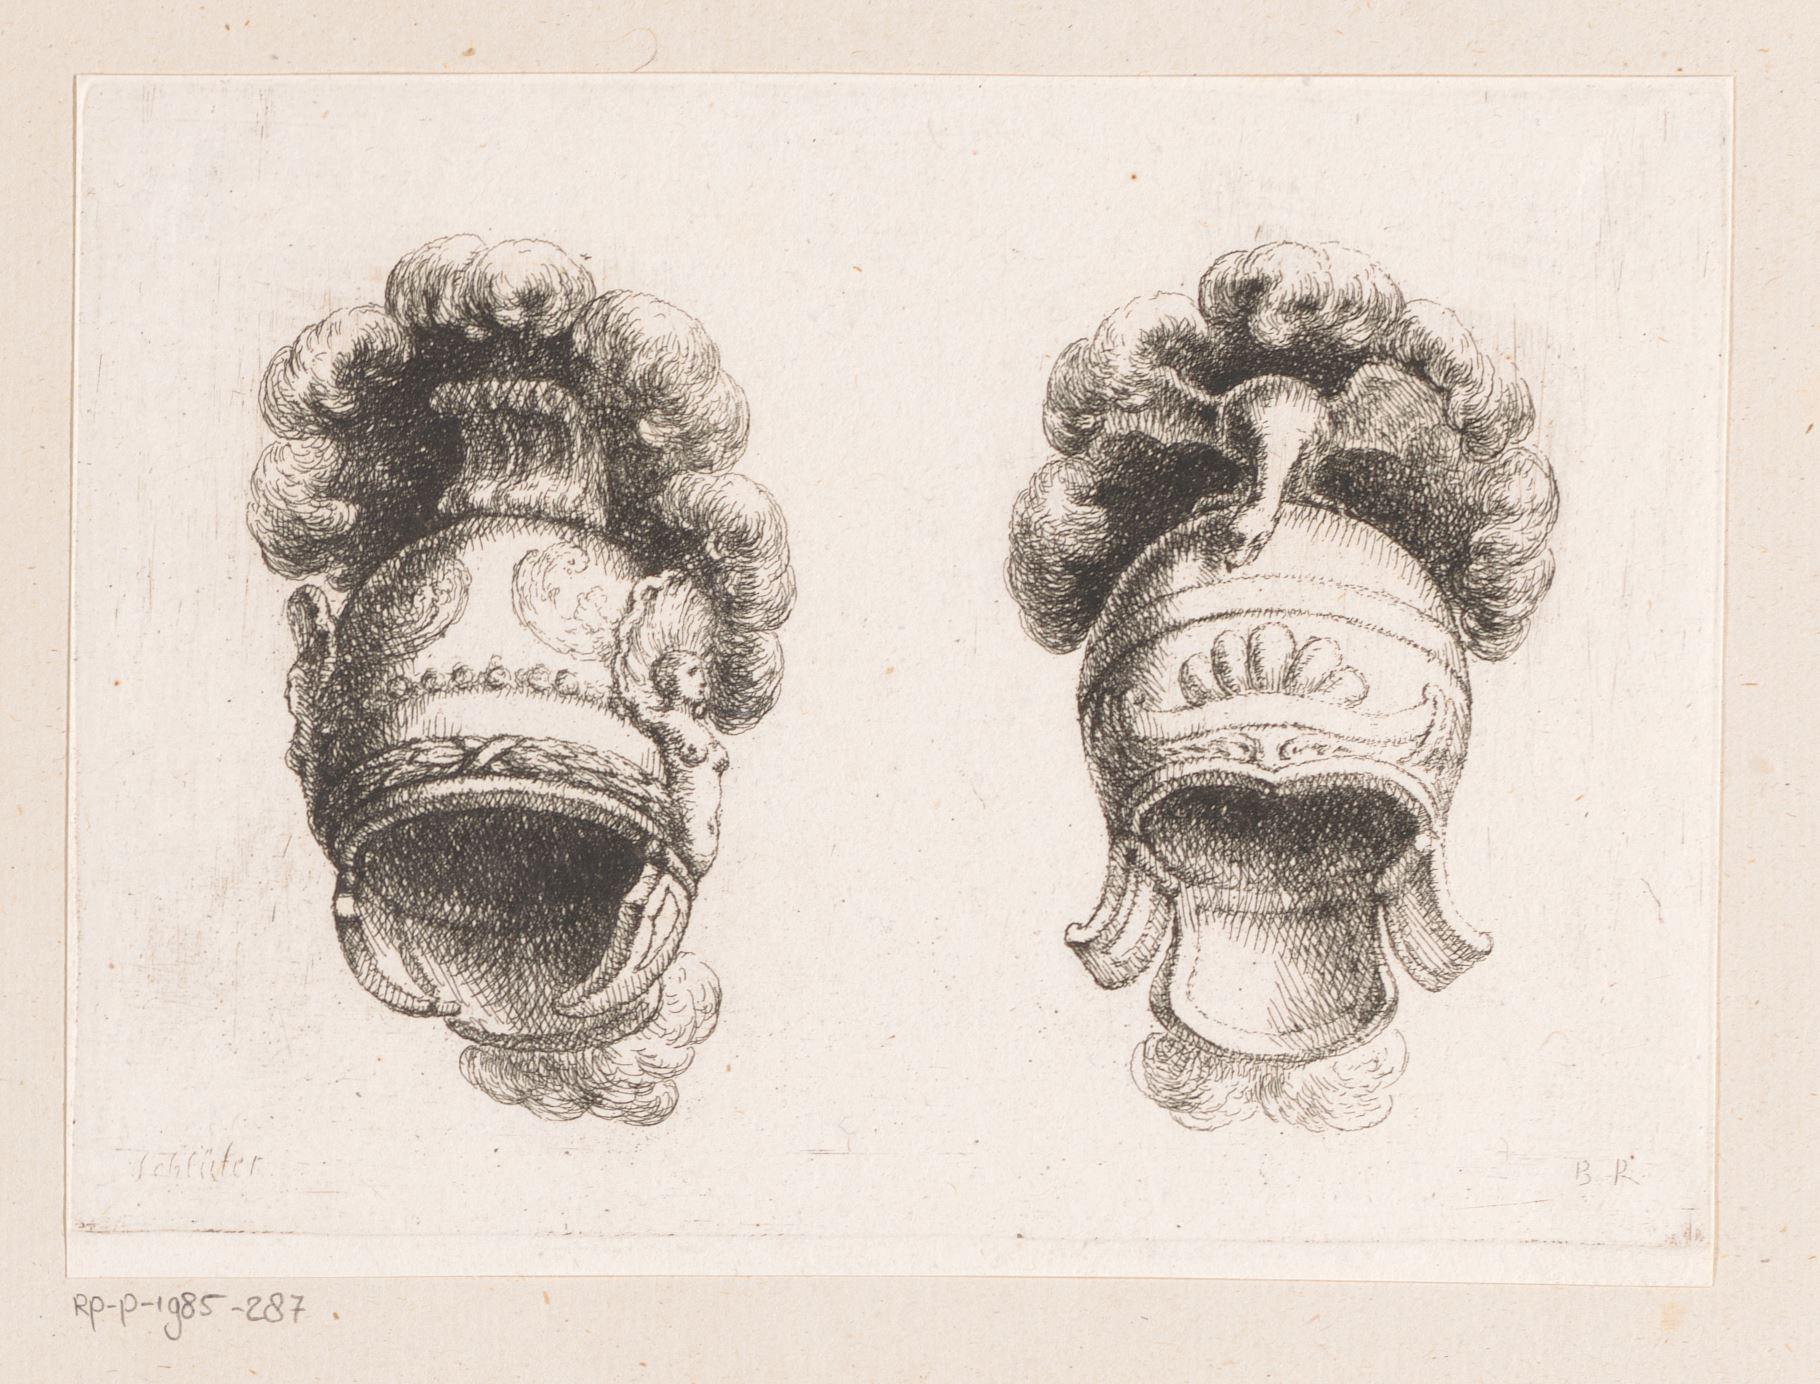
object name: print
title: Mascarons en helmen van het Zeughaus te Berlijn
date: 1759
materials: paper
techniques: etching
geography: berlin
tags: helmet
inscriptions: collector's mark: Lugt 2760, collector's mark: Lugt 2228